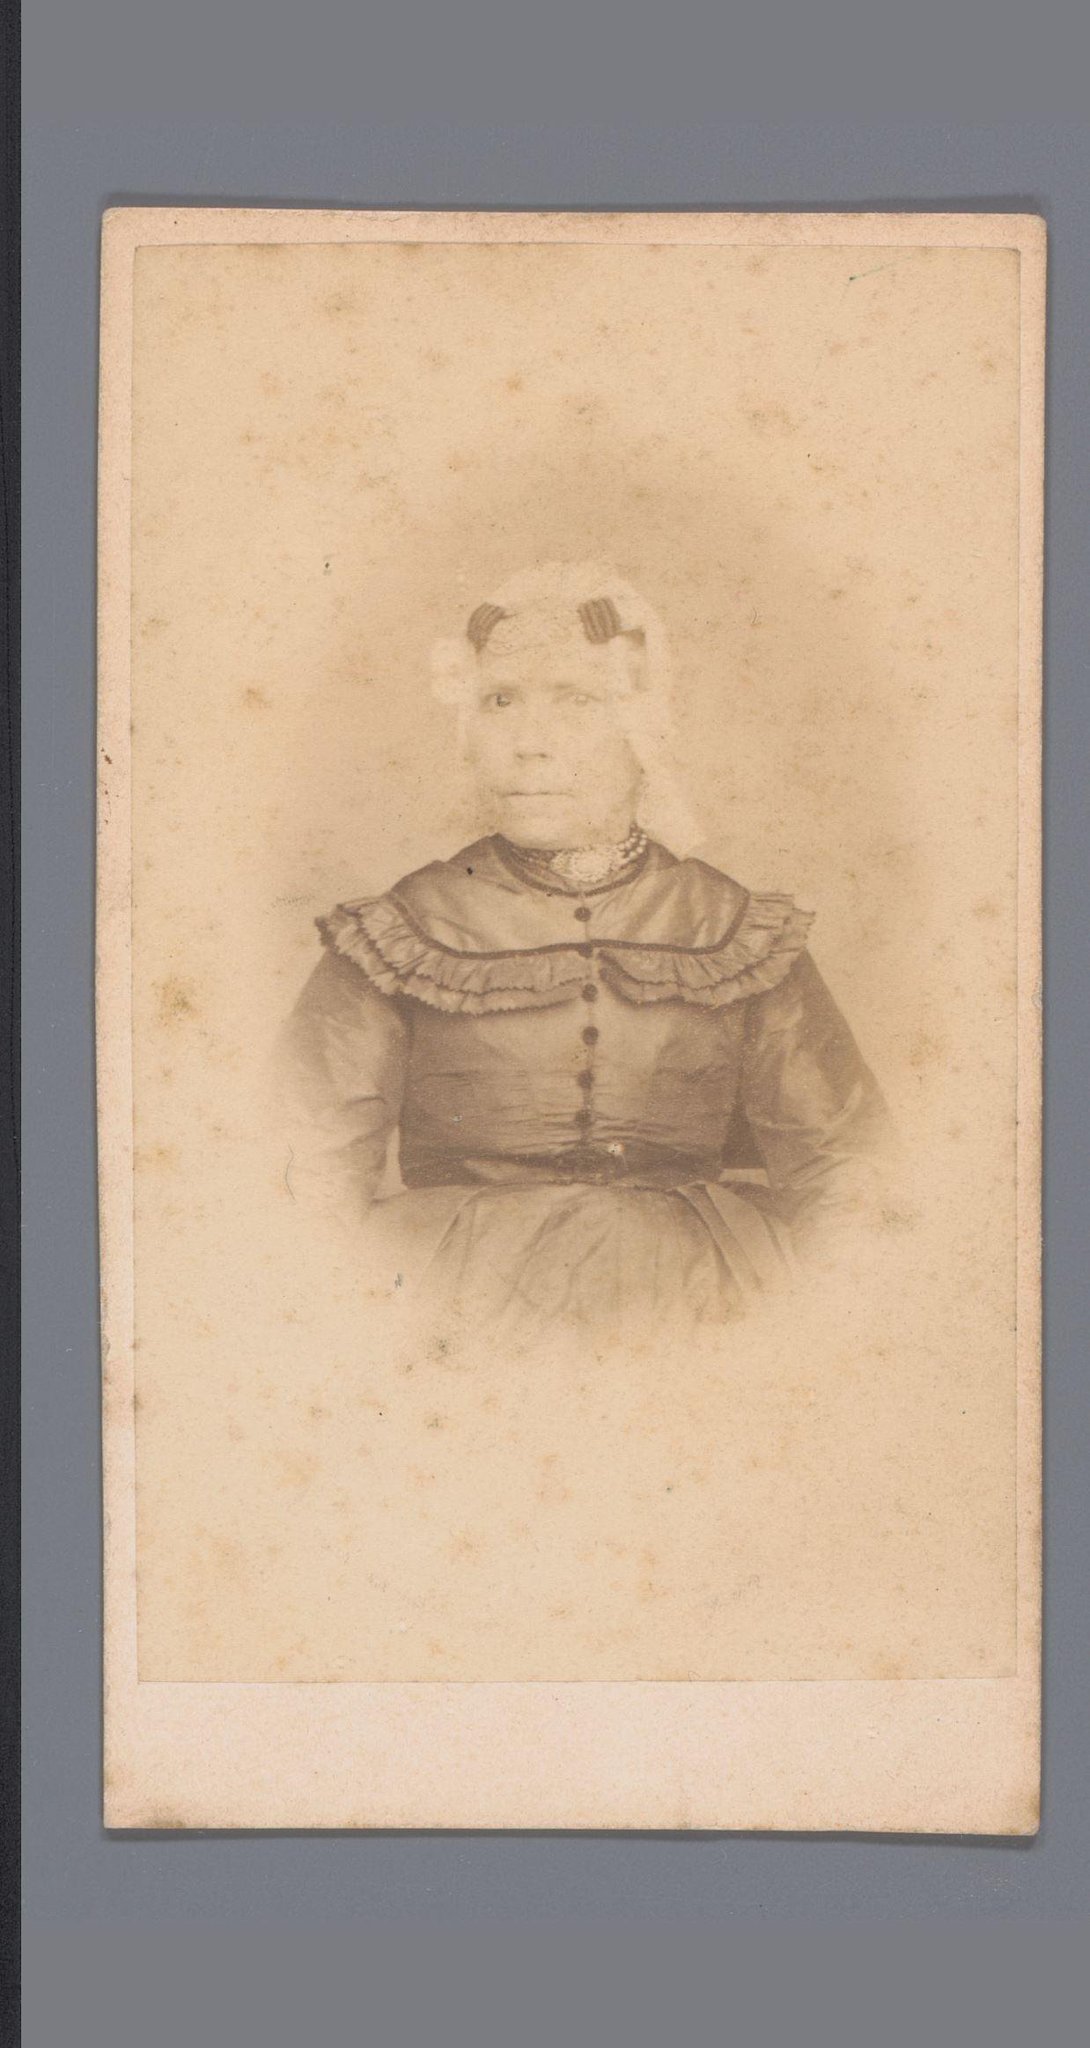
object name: photograph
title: Portret van een onbekende vrouw met een muts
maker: Anonymous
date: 1855-1885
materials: cardboard, paper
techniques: albumen print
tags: historical persons - bb - woman, head-gear: cap